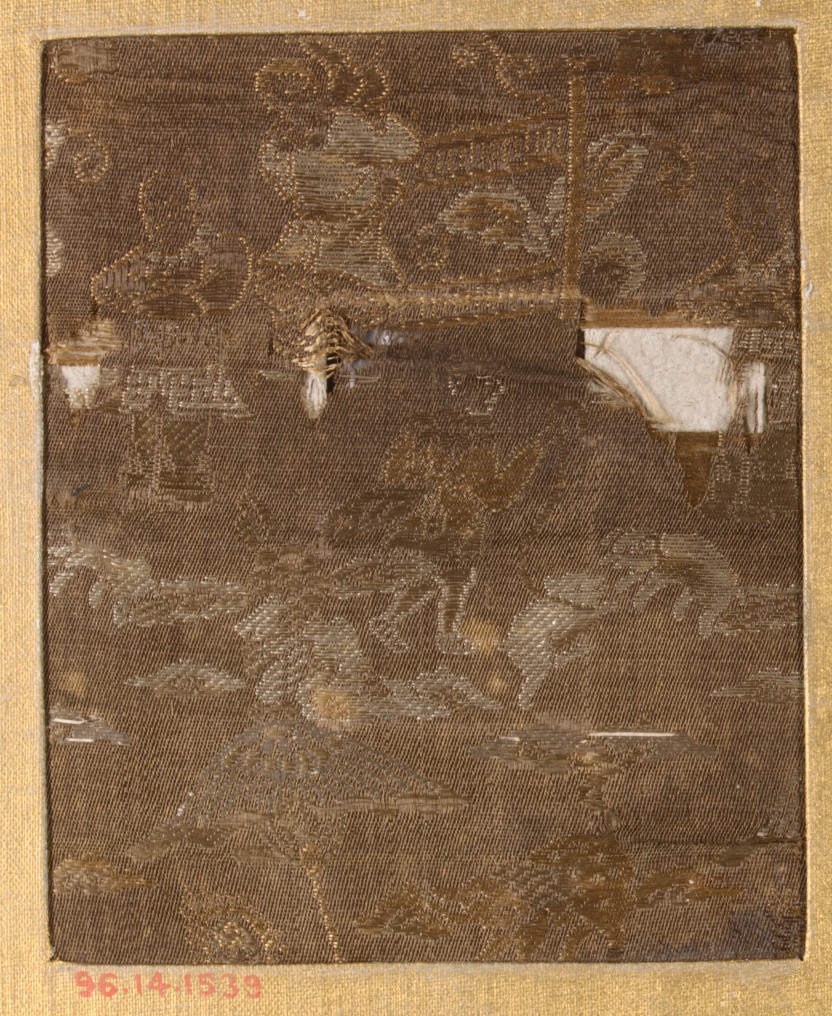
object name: piece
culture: japanese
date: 1701-1900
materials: silk